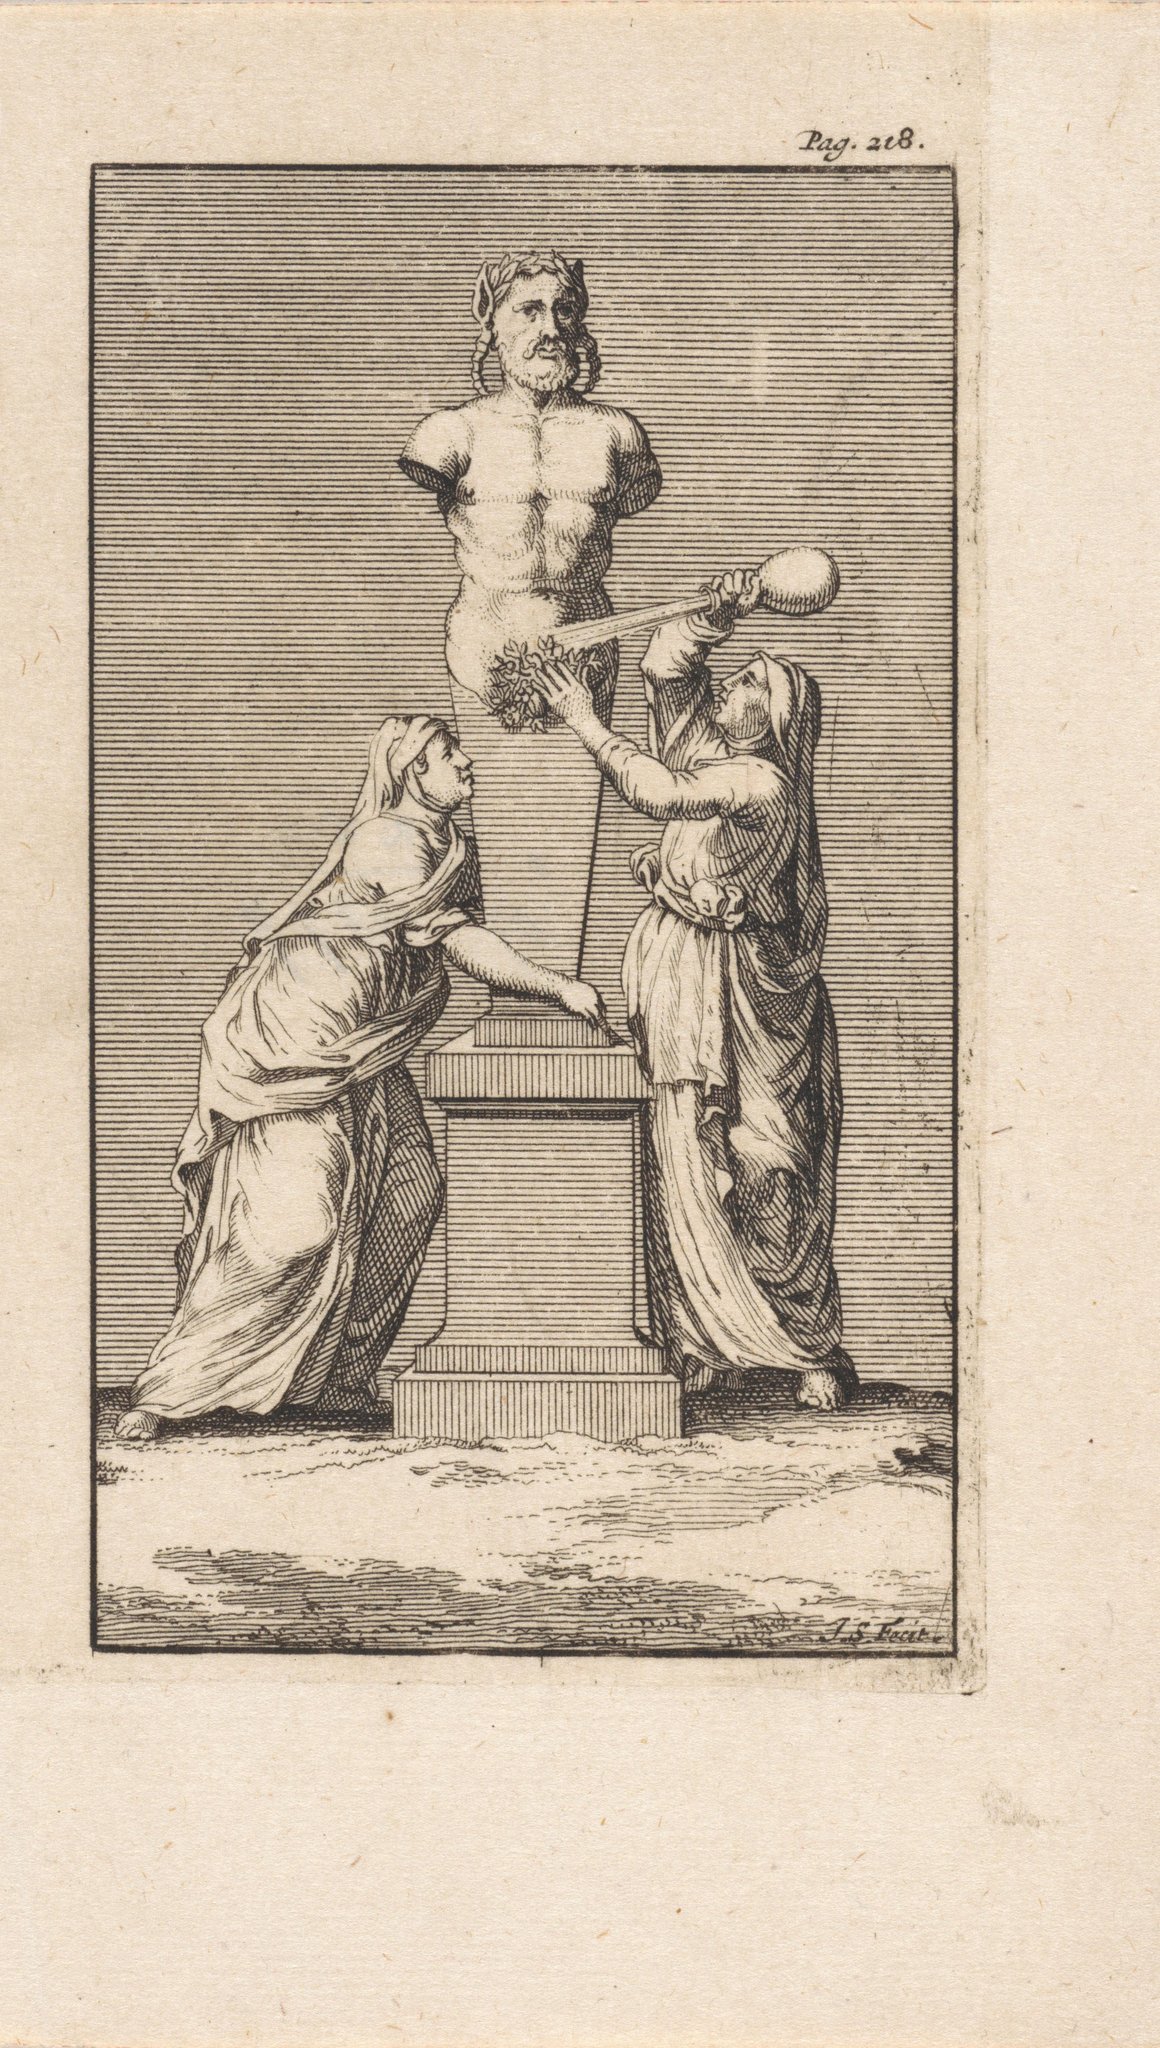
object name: print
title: Vrouwen aanbidden het beeld van Priapus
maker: jacobus schijnvoet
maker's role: draughtsman, print maker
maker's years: 1685-1743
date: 1713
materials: paper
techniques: etching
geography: amsterdam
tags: (story of) priapus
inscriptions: collector's mark: Lugt 2228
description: Illustratie mogelijk uit: Brouërius van Nidek, Matthaeus. De populorum veterum ac recentiorum adorationibus dissertatio. Amsterdam: Johannes van Oosterwyk, 1713.